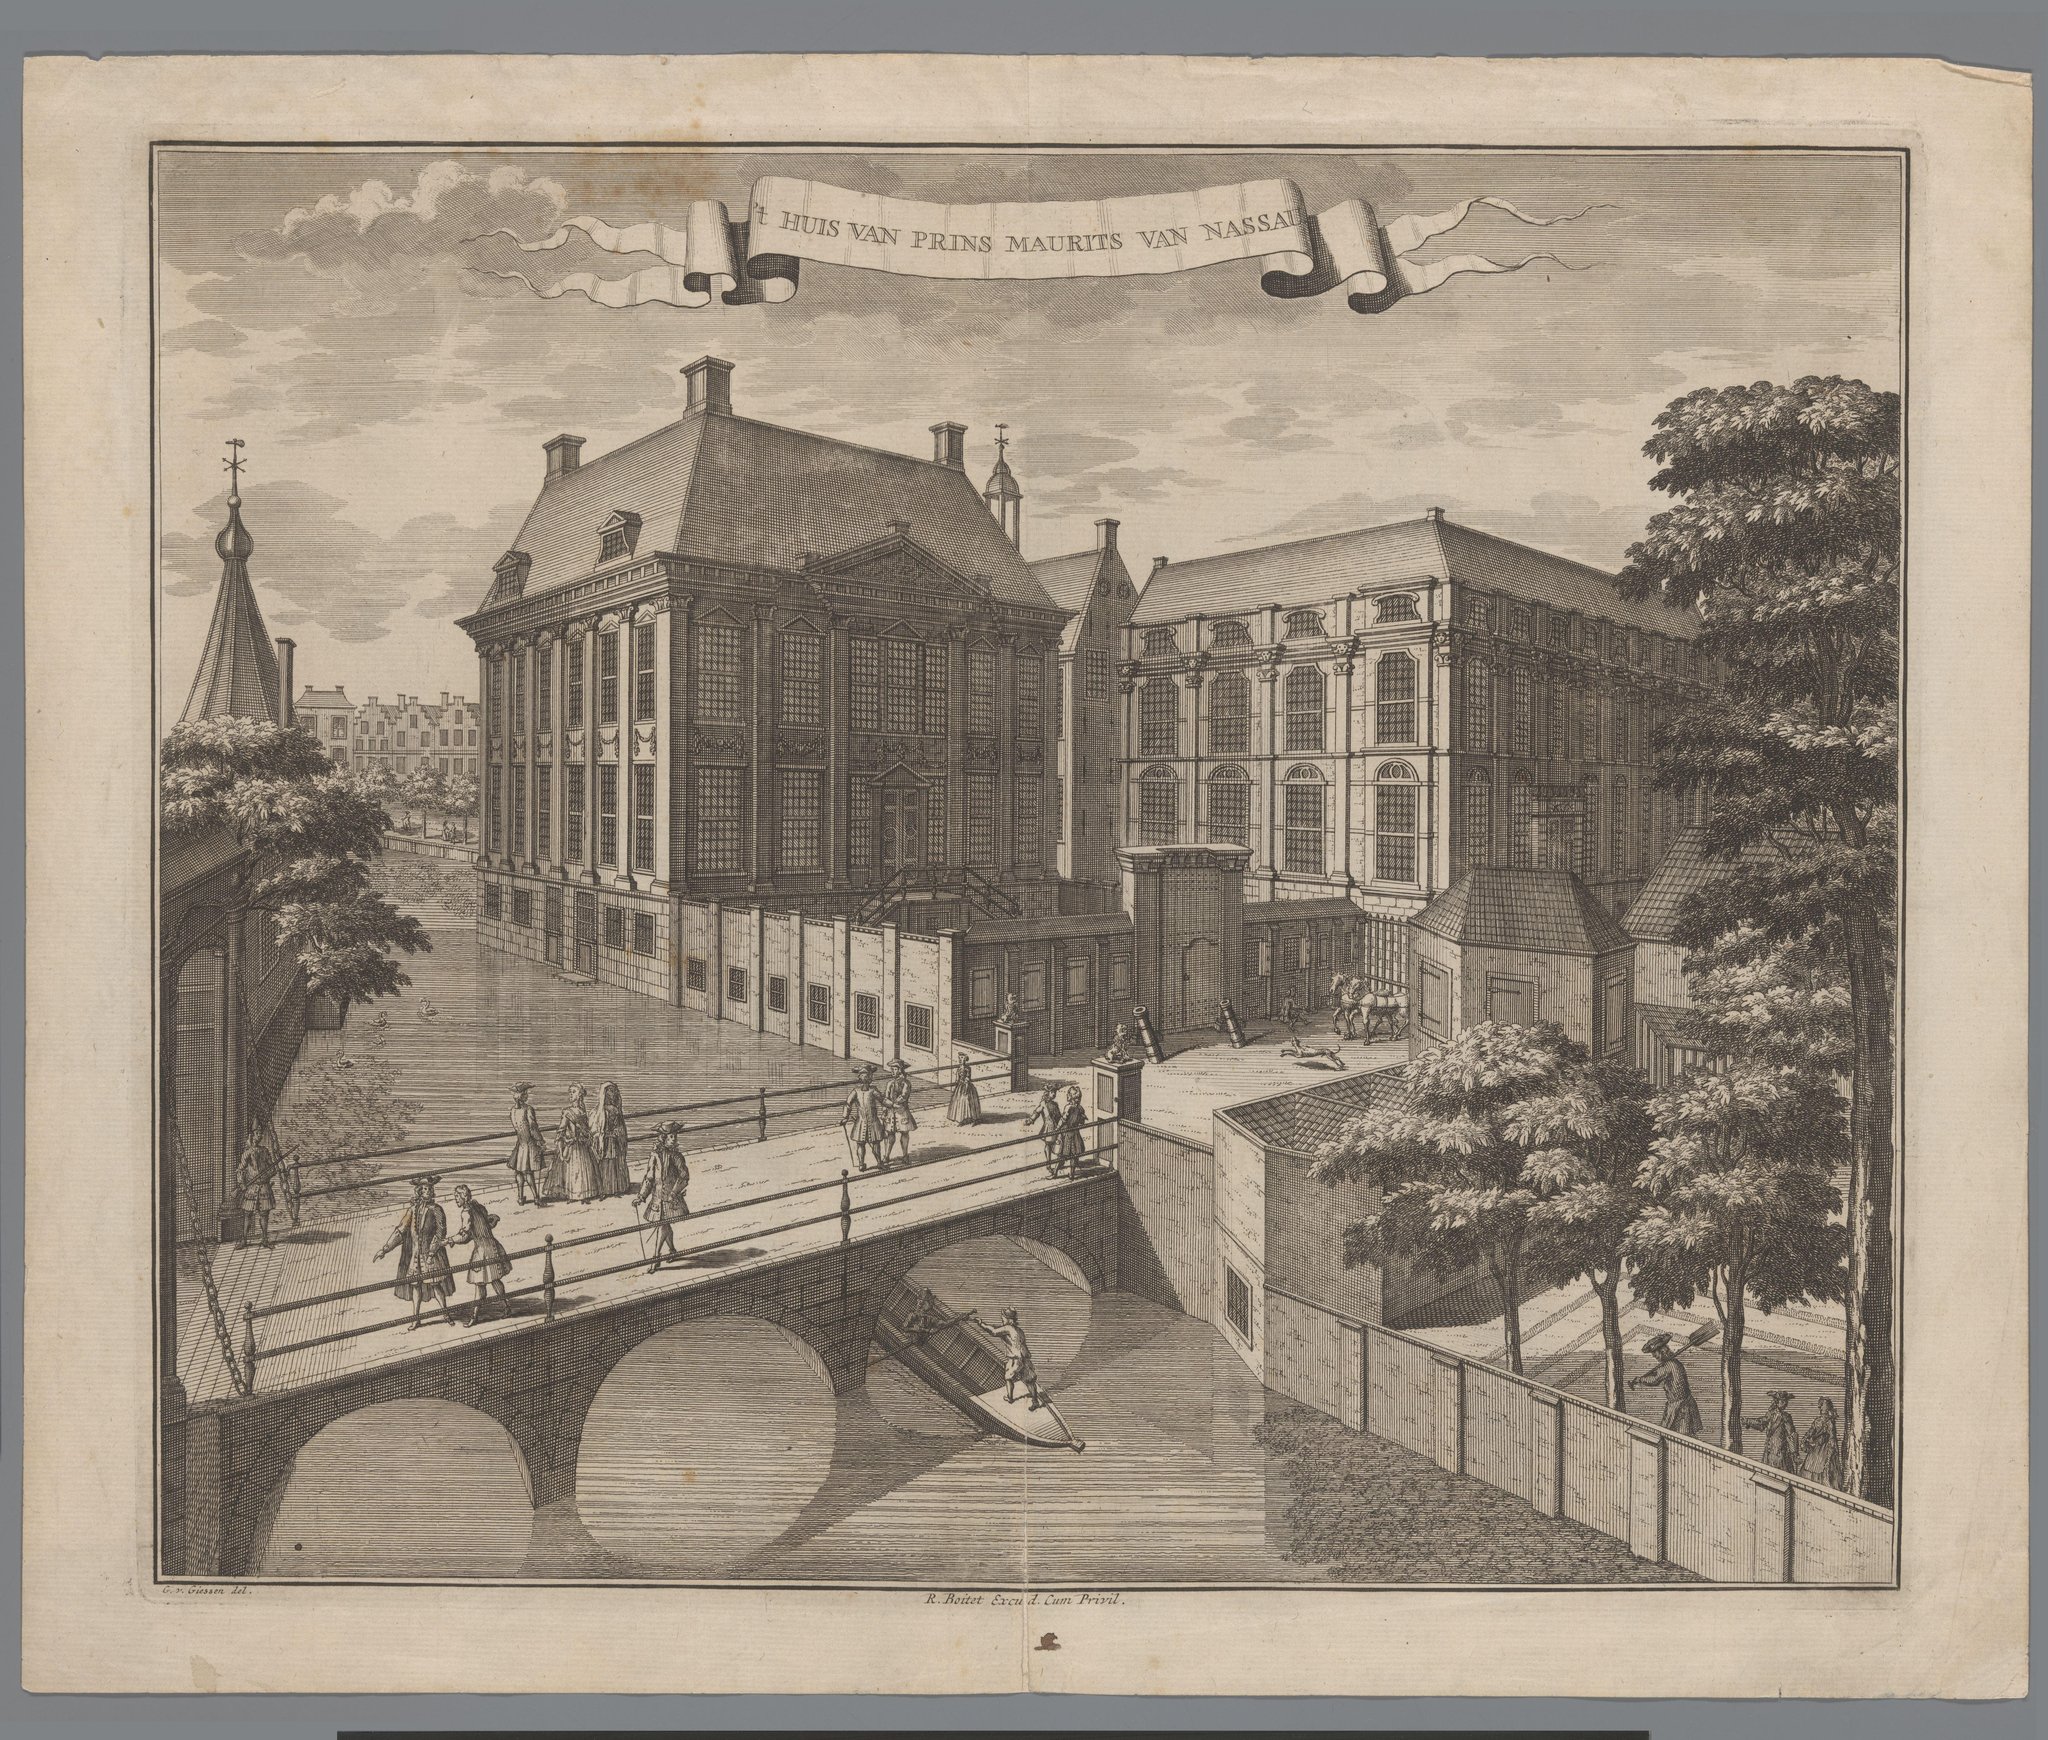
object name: print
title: 't Huis van prins Maurits van Nassau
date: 1730-1736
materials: paper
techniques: engraving, etching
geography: the hague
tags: exterior ~ representation of a building, bridge, street (+ city(-scape) with figures, staffage)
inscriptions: collector's mark: Lugt 2228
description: Prent ook gebruikt in: Riemer, Jacob de. Beschryving van 's-Graven-Hage, behelzende deszelfs oorsprong, benaming, gelegentheid, uitbreidingen, onheilen en luister; mitsgaders (…). 2 dln. Delft: Reinier Boitet, 1730. Tevens gebruikt in de uitgave uit 1736 (Adrianus Douci).